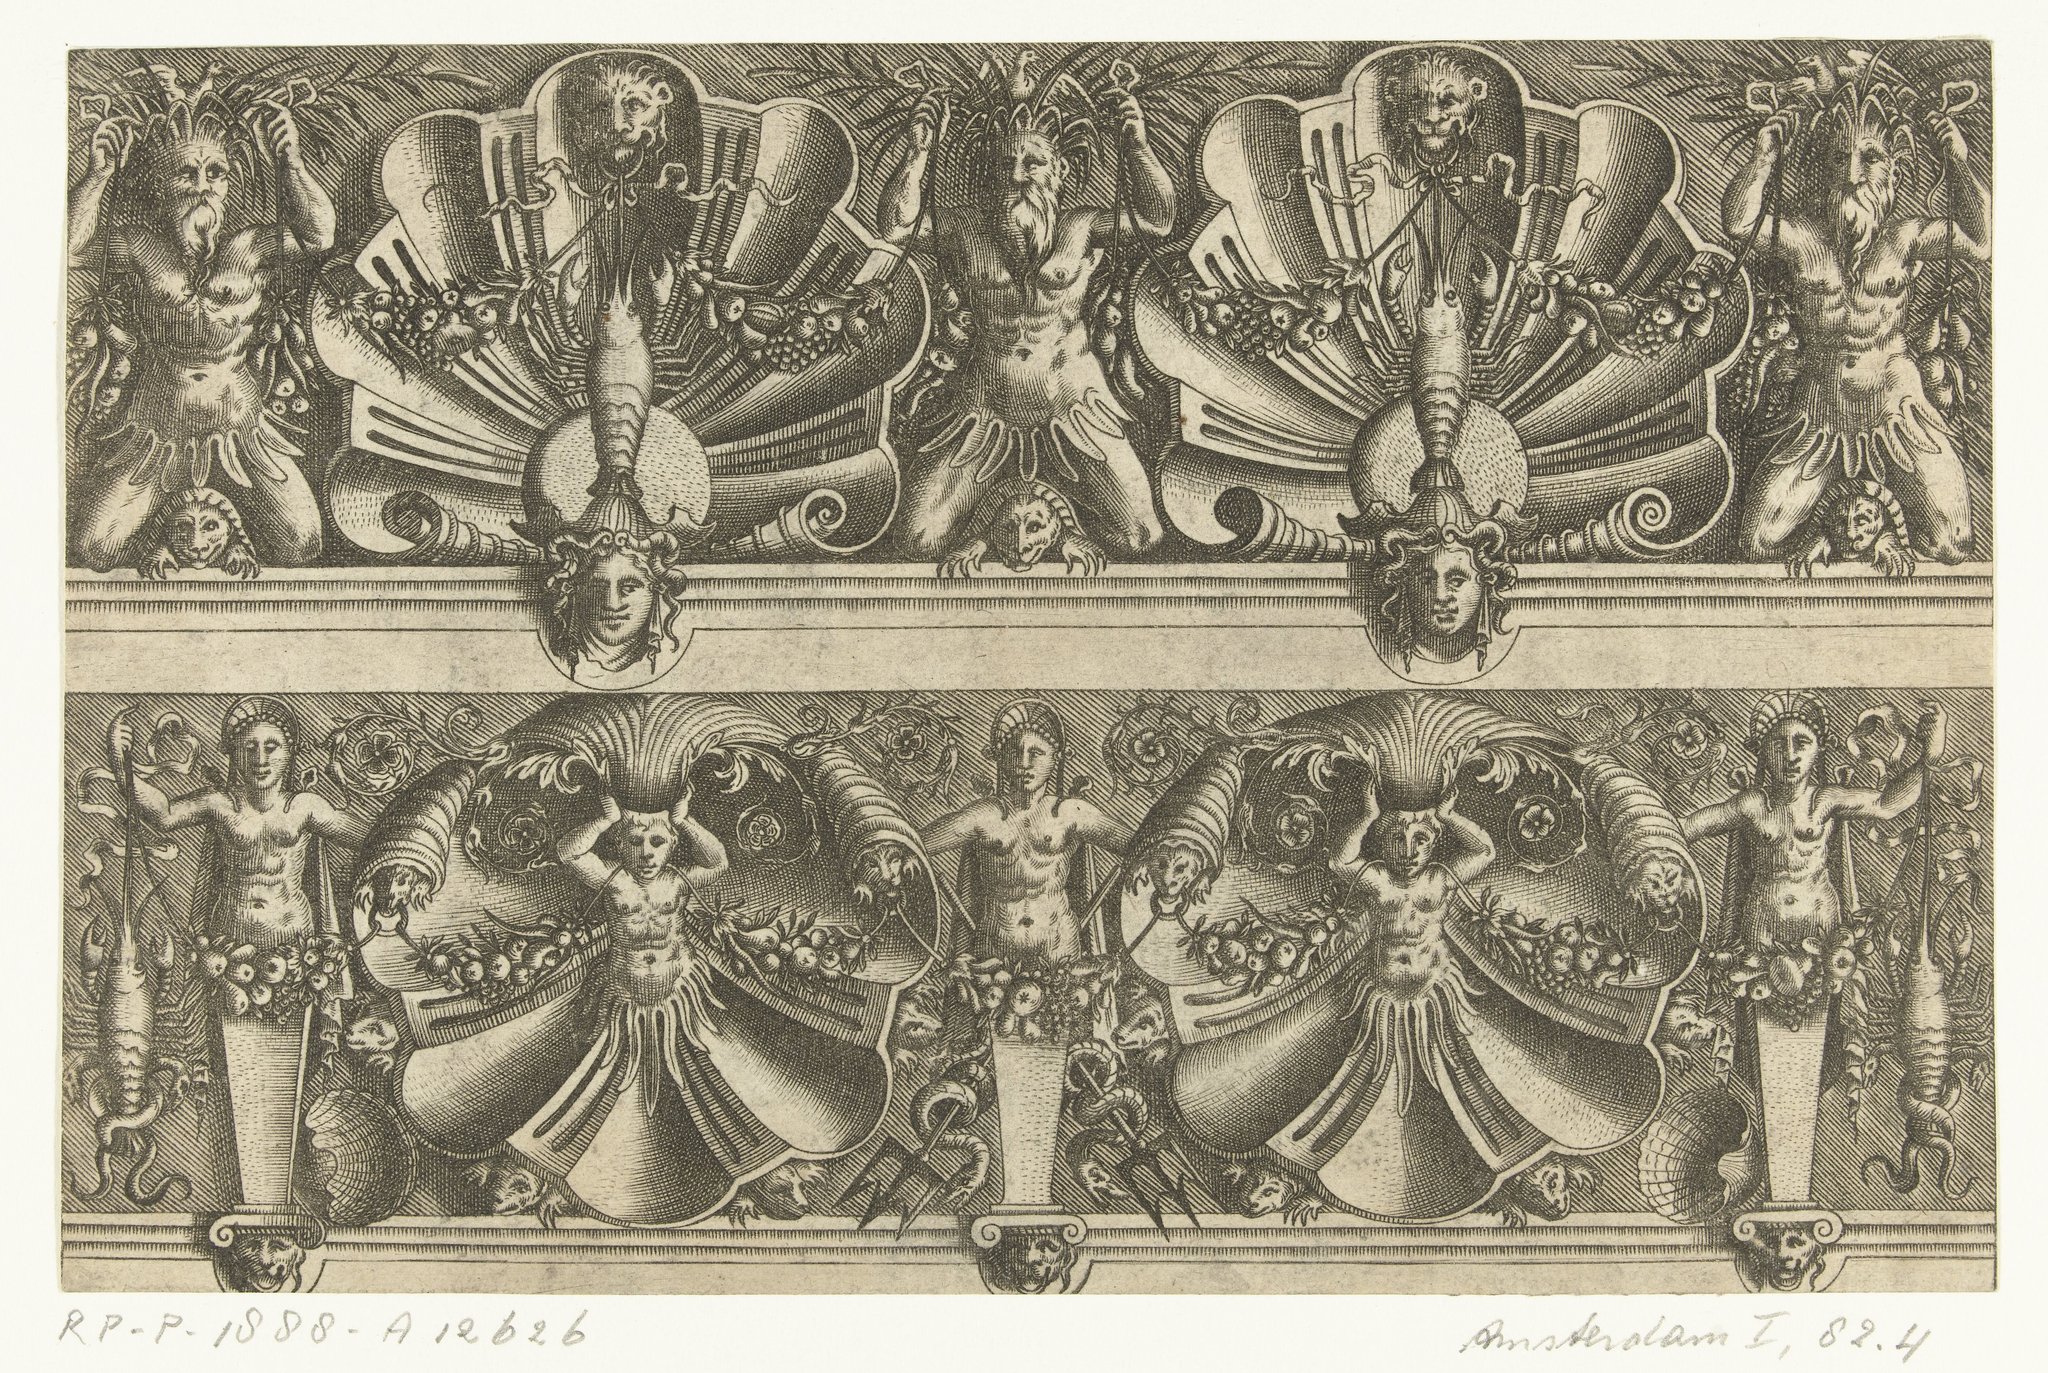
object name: ornament print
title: Compertimenta pictoriis flosculis manubiisque…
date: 1567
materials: paper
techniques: engraving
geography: netherlands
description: In het bovenste fries knielen drie mannen met een vogelnest op hun hoofd. Tussen hen bevinden zich twee schelpen. In het onderste fries staan drie vrouwelijke hermen, eveneens met twee schelpen tussen hen in. Gearceerde achtergrond. Hoort bij serie van 14 bladen cartouches met rolwerk, grotesken, trofeeën en friezen. Het titelblad ontbreekt.